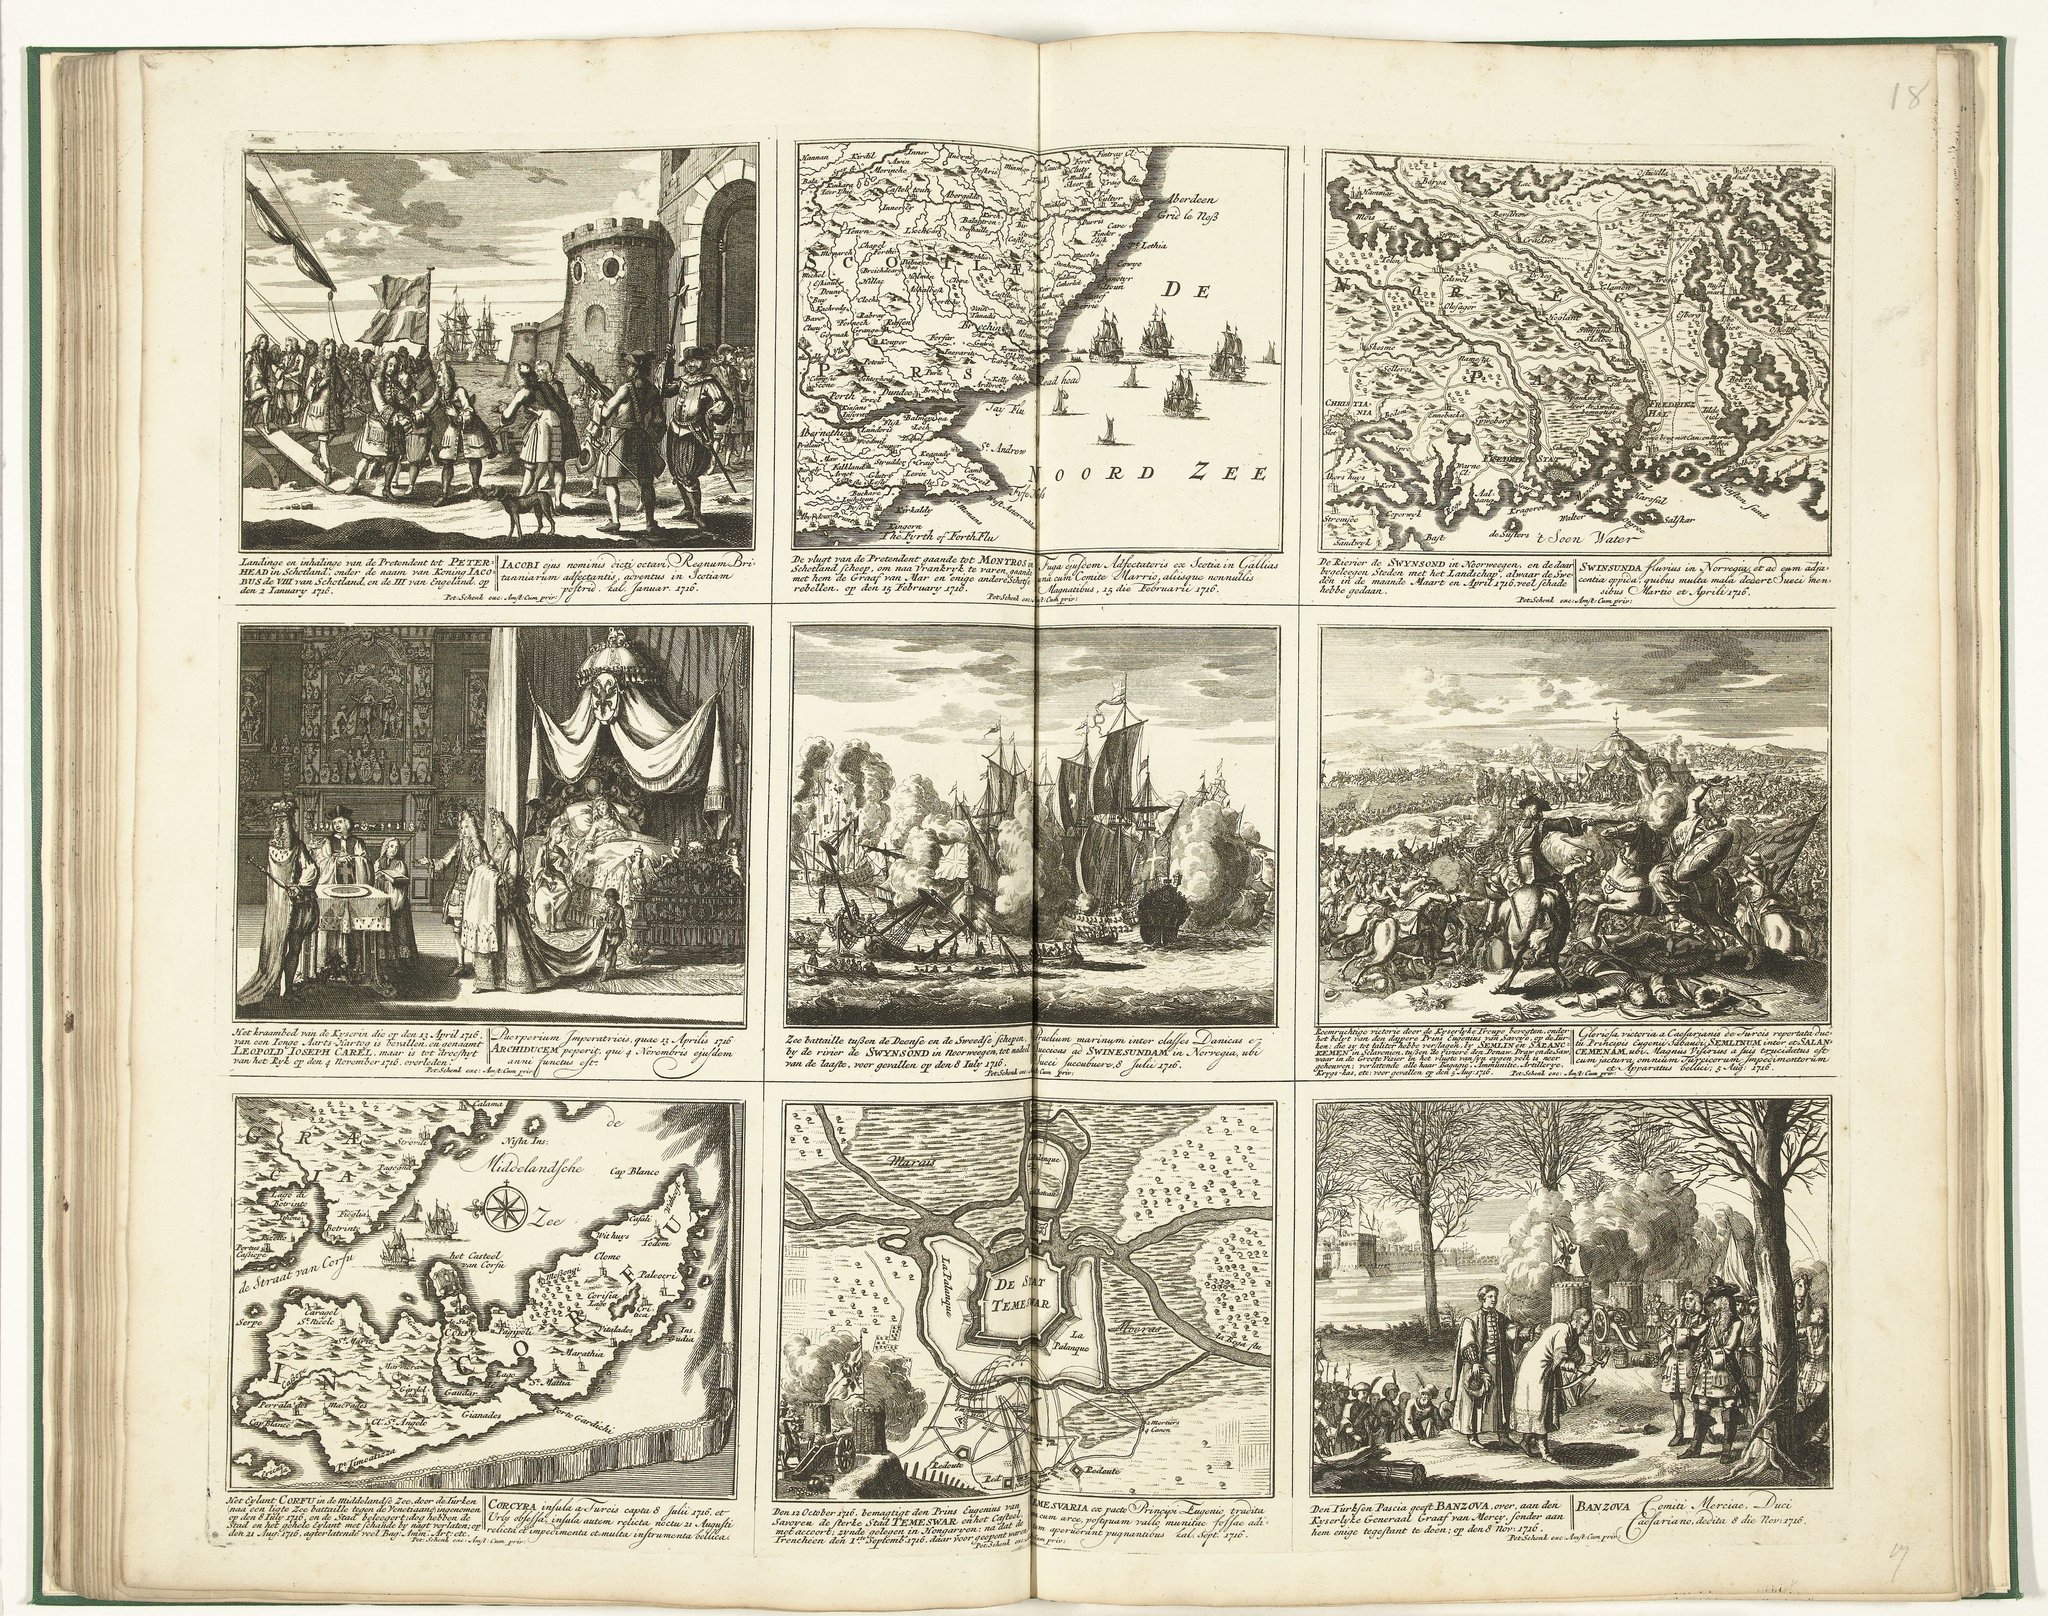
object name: print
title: Schouwburg van den Oorlog, Beginnende van Koning Karel den II. Tot op Koning Karel den III. Bestaande in IX. Historische Figuren op een Olifants Blad, als Veldslagen, Belegeringen te Water en te Lande, met de voornaamste Vestingen (...)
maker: pieter schenk (i)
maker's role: print maker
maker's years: 1660-1711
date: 1716-1720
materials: paper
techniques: etching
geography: amsterdam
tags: london, paris, vienna, eugenius van savoye, maps of separate countries or regions, battle (+ naval force), battle (+ land forces), confinement, birth, norway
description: Blad met negen voorstellingen van gebeurtenissen uit het jaar 1716 en enkele kaarten. Blad XVII in: Schouwburg van den oorlog (editie van 1720), het prentwerk met de gebundelde reeks van 31 platen over de Spaanse Successieoorlog.